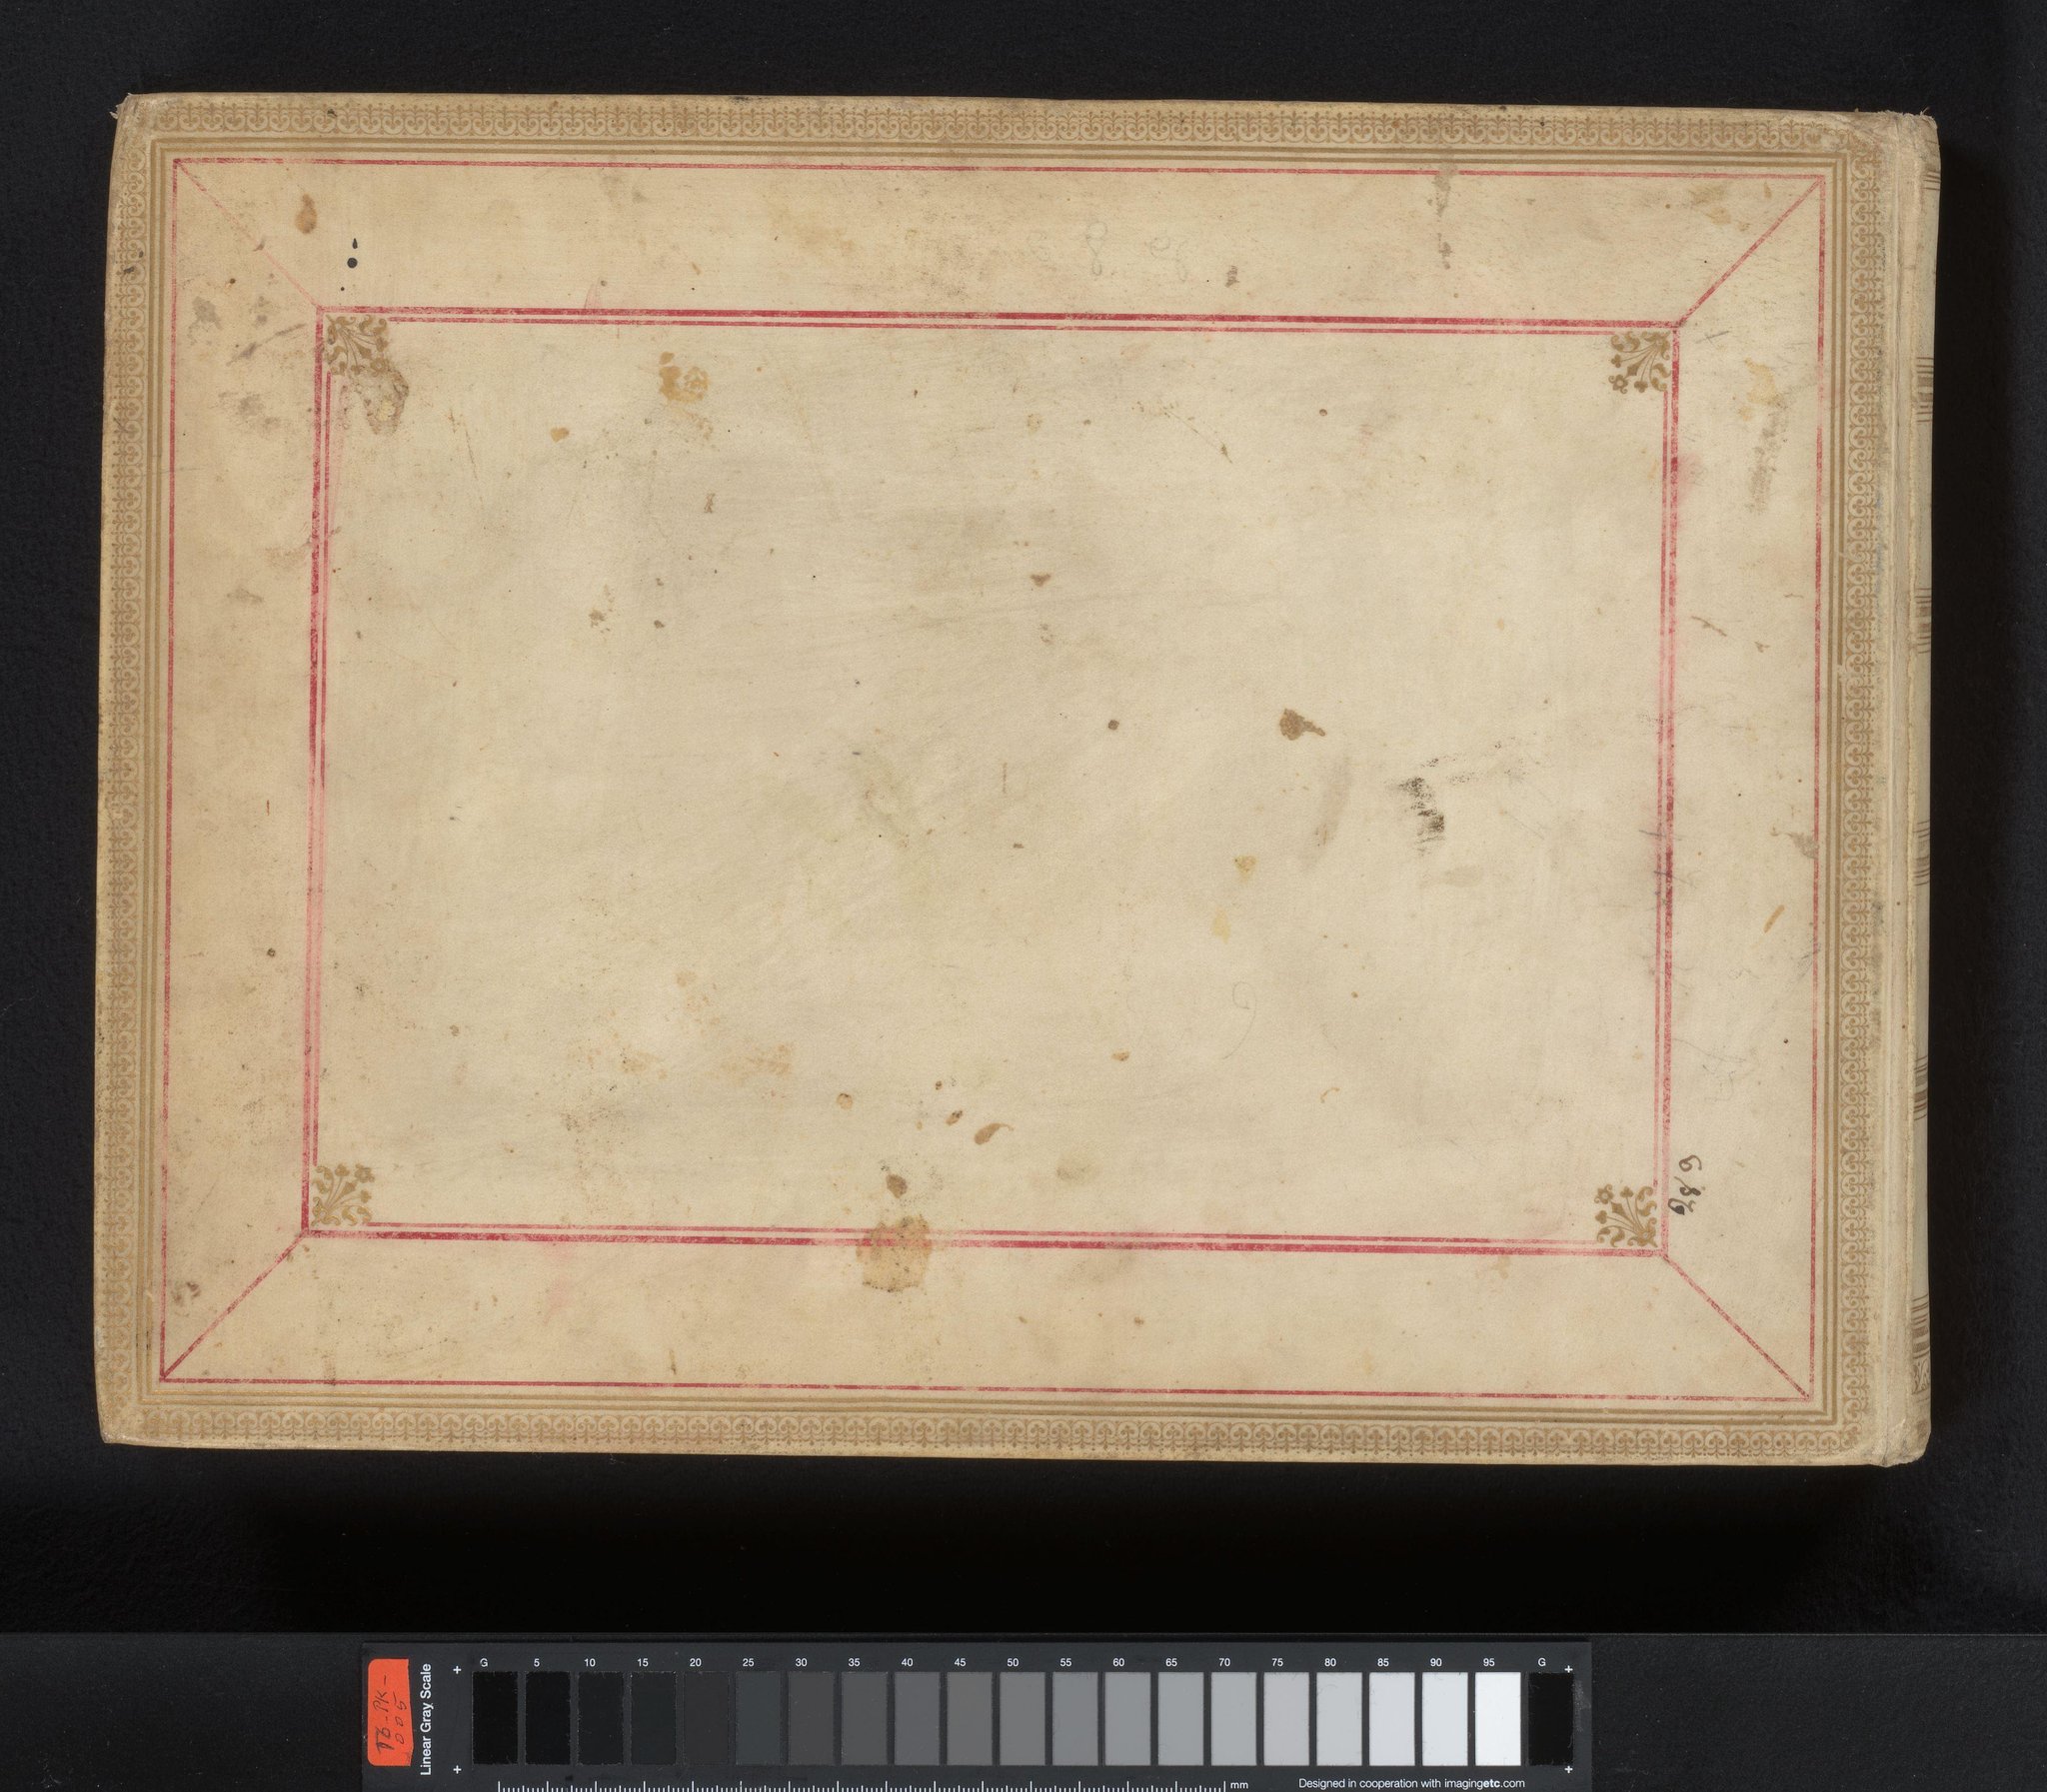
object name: photograph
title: Gezicht op de Boog van Constantijn in Rome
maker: Anonymous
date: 1870-1895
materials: cardboard, photographic support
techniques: albumen print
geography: rome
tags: triumphal arch, arch of constantine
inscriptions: inscription: ‘10 ARCO DI CONSTANTINO COLLA META SUDANTE’